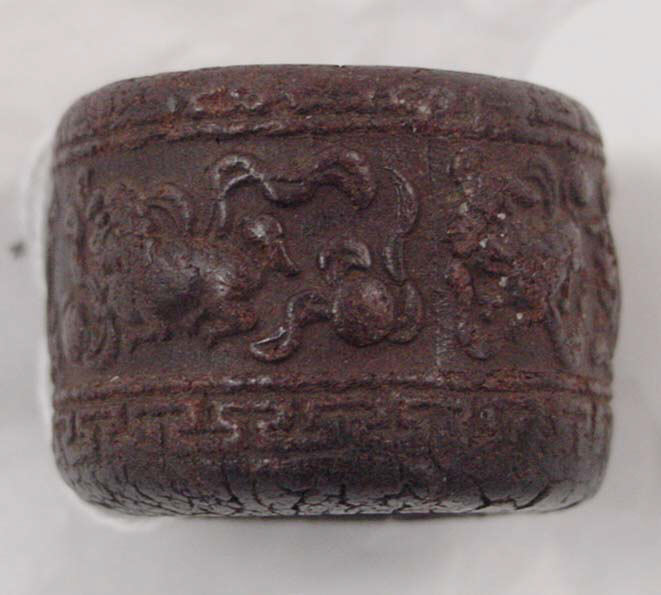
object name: ring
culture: chinese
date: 1801-1900